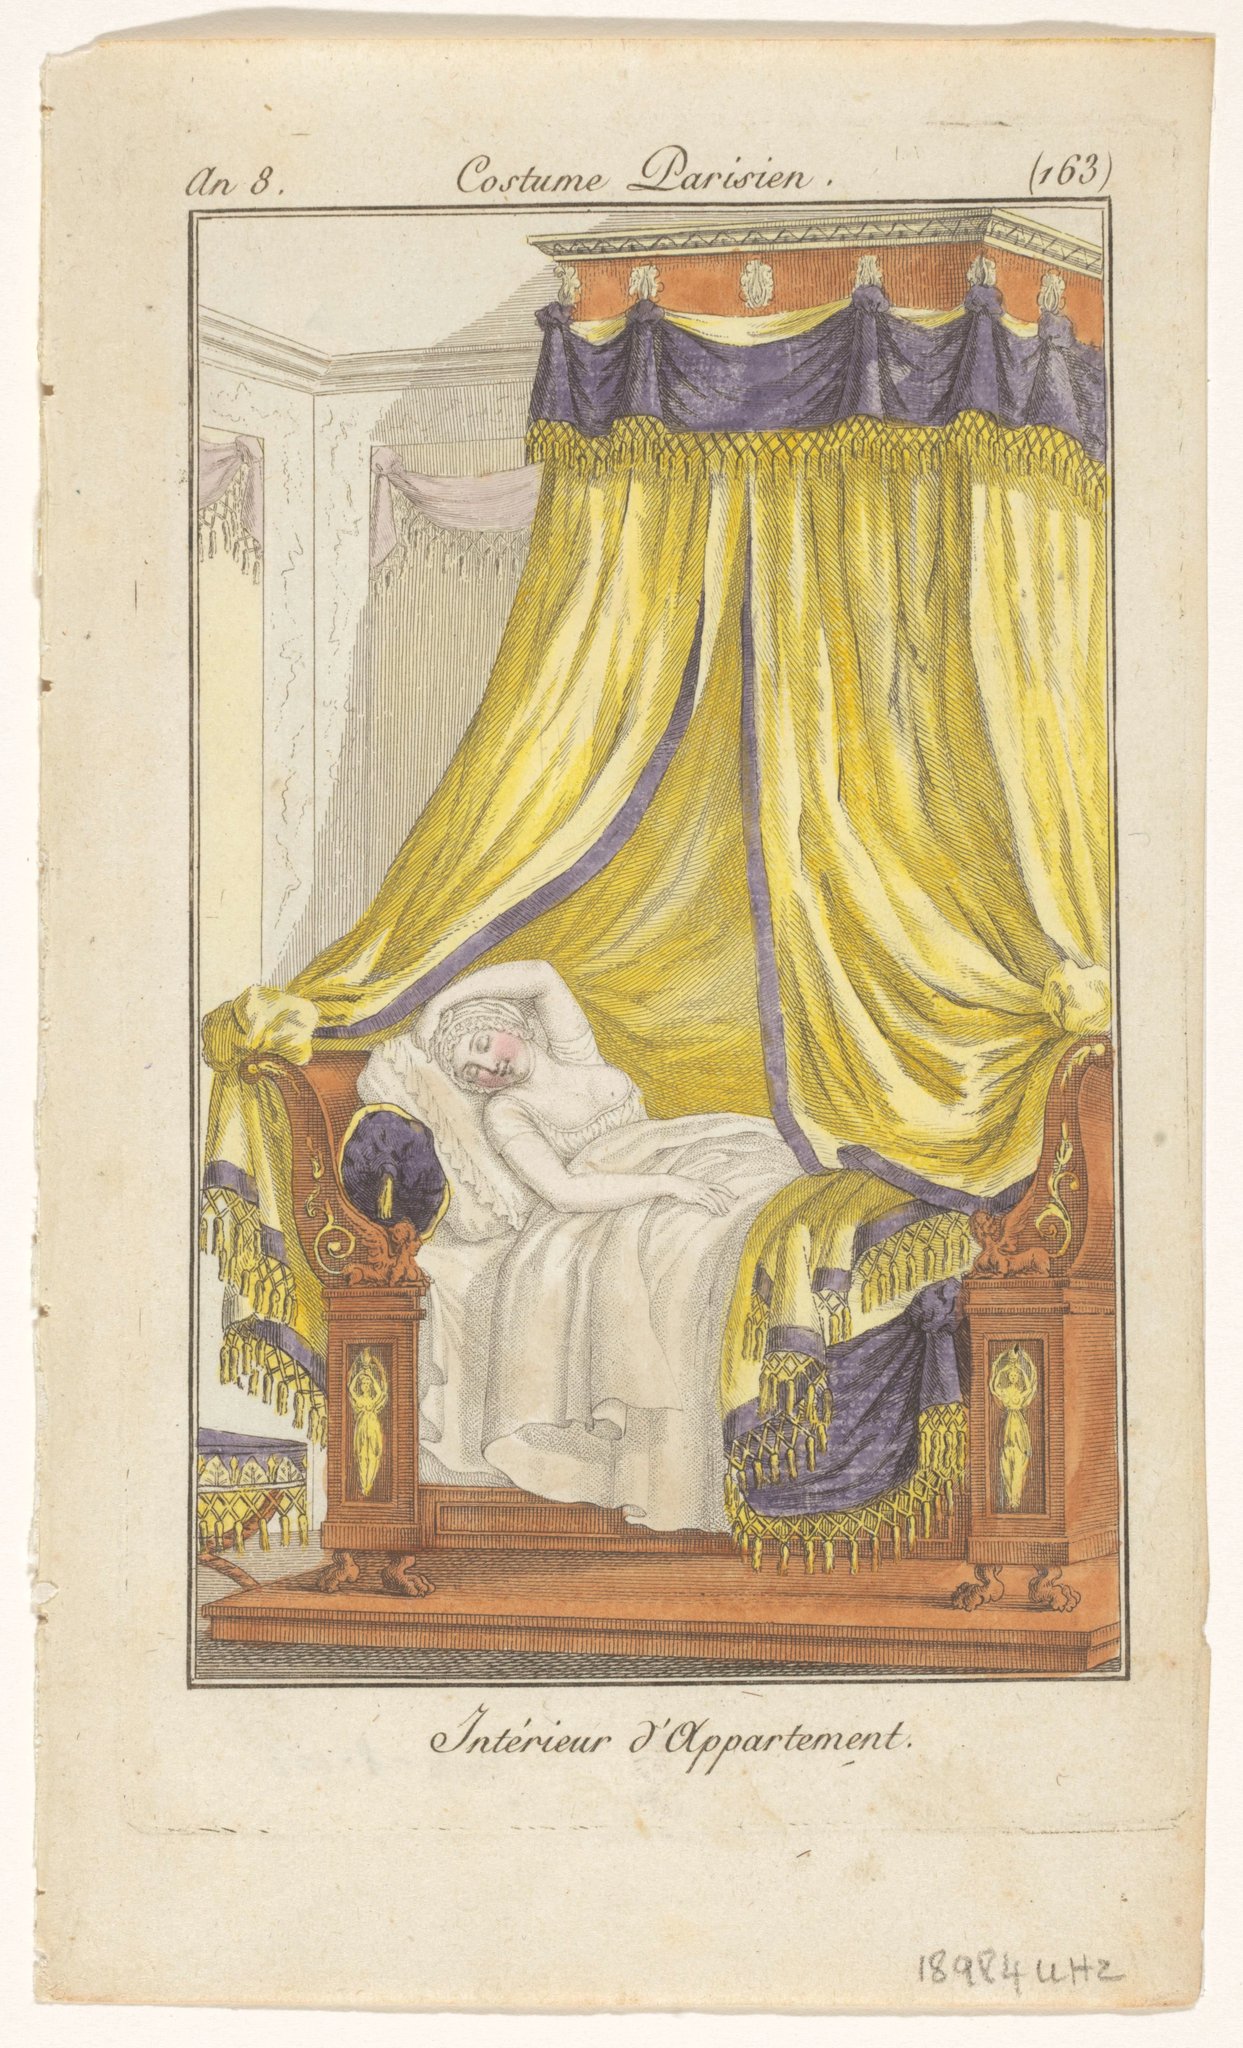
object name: fashion print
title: Intérieur d'Appartement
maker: Anonymous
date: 1799-1800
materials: paper, ink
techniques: etching, hand coloring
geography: france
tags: bed with tester, fashion plates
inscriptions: collector's mark: Lugt 2228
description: Slaapkamerinterieur met een jonge vrouw in een hemelbed. Prent genomen uit het modetijdschrift Journal des Dames et des Modes, Costume Parisien, An 8 [1799-1800], nr. 163.